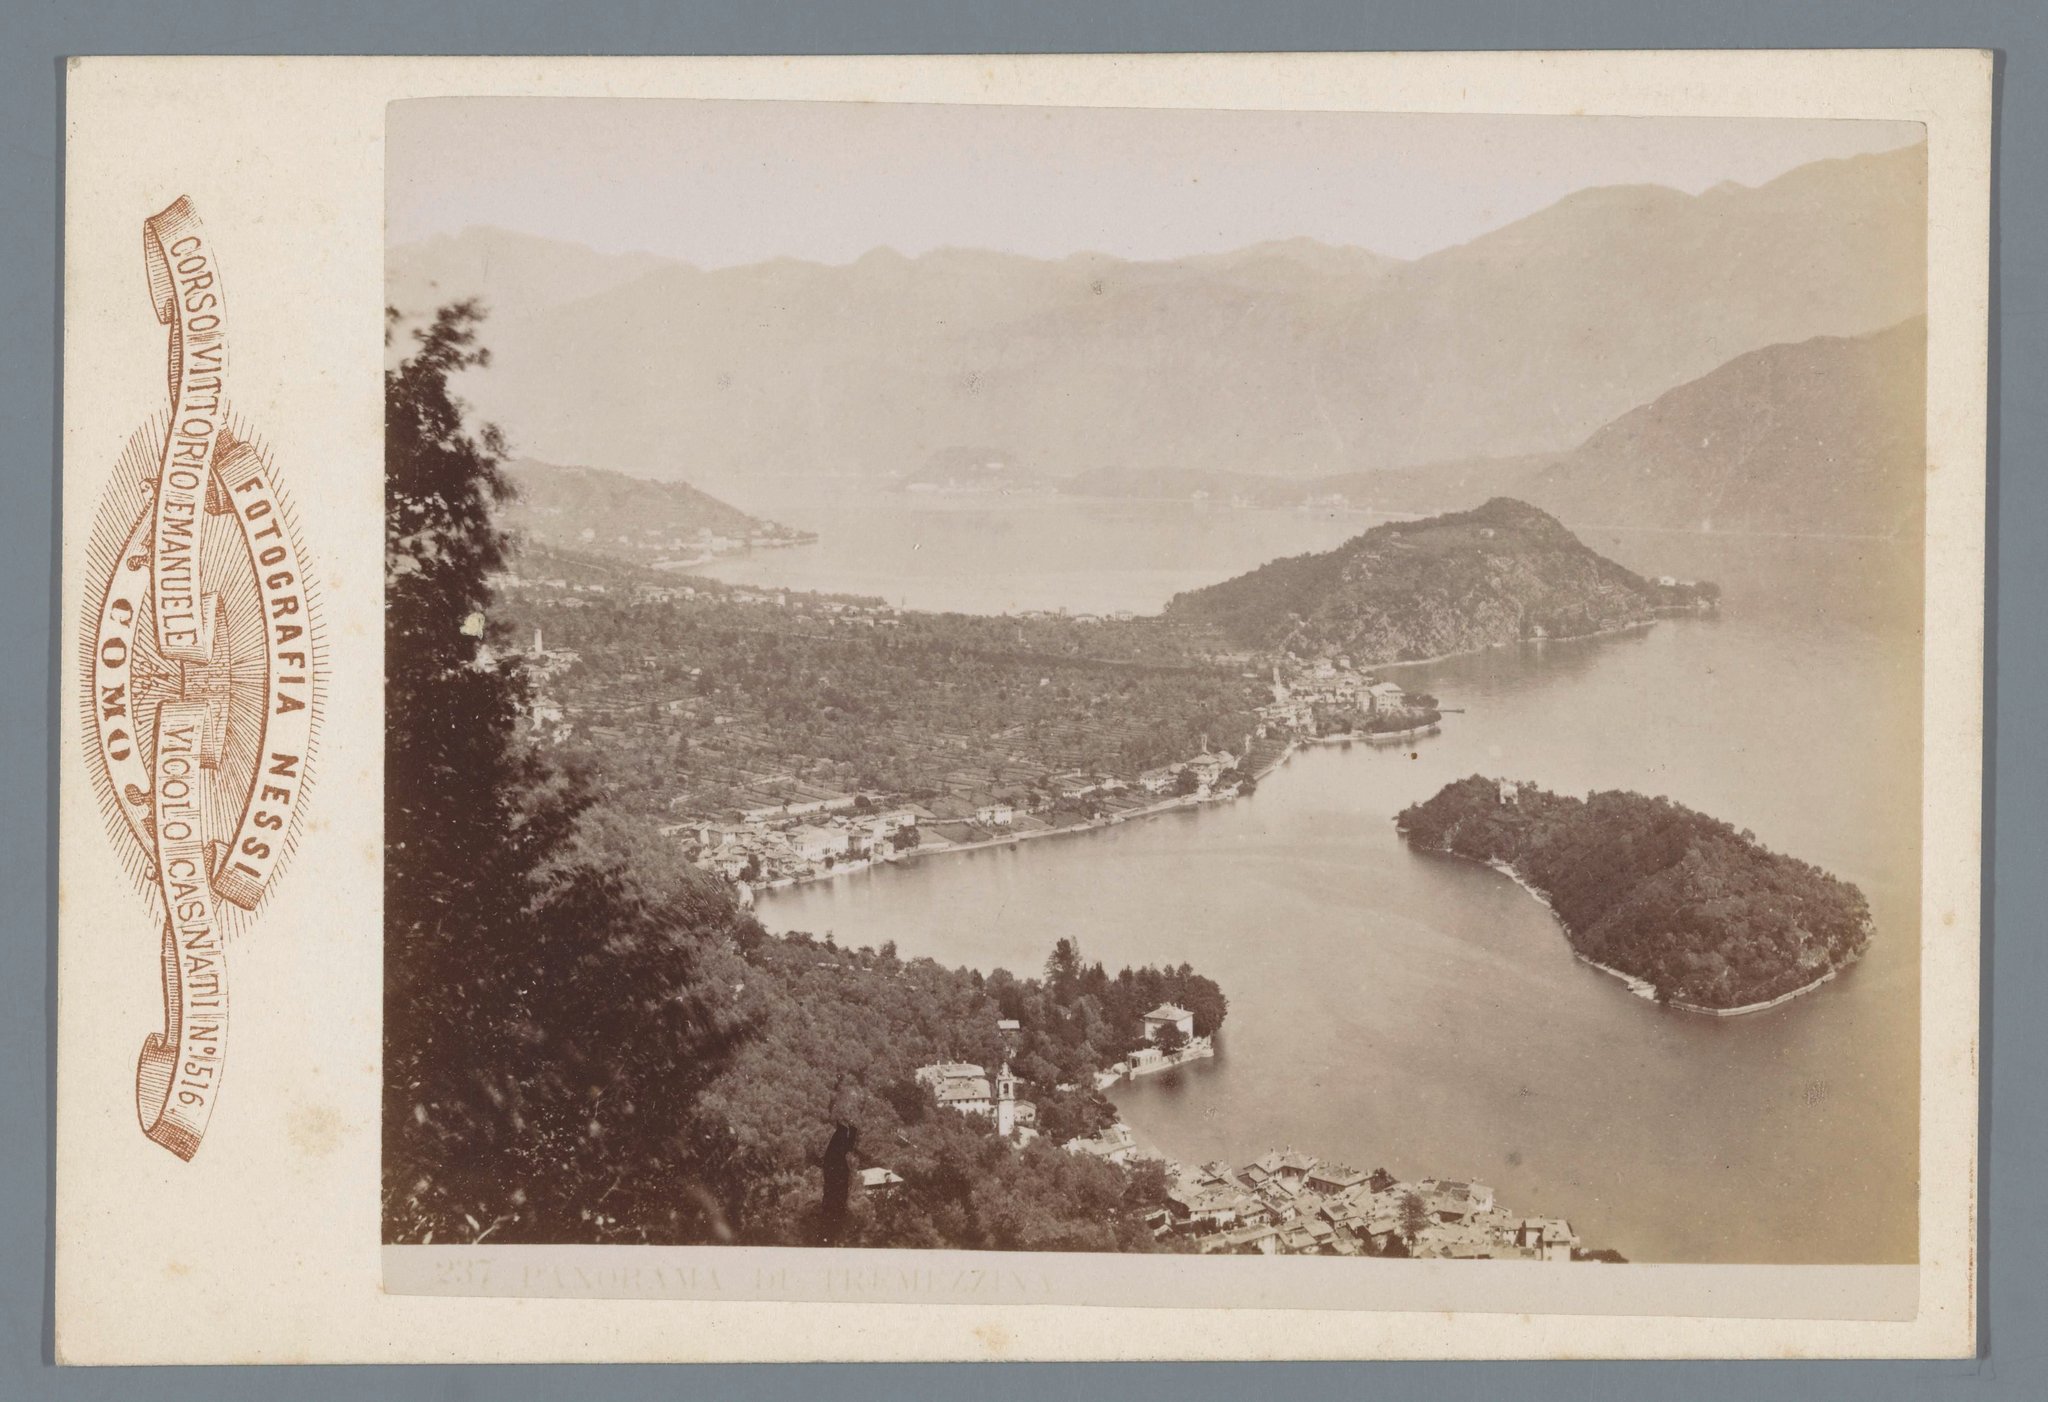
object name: cabinet photograph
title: Panorama di Tre [...]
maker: antonio nessi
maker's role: fotograaf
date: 1860-1870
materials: cardboard, photographic support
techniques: albumen print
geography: como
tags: lake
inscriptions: address: ‘Corso Vittorio Emanuele Vicolo Casnati No. 516.’, annotation: ‘Panorama van het/ meer van Como./ Bellagio 17 Aug 75’, number: ‘237’